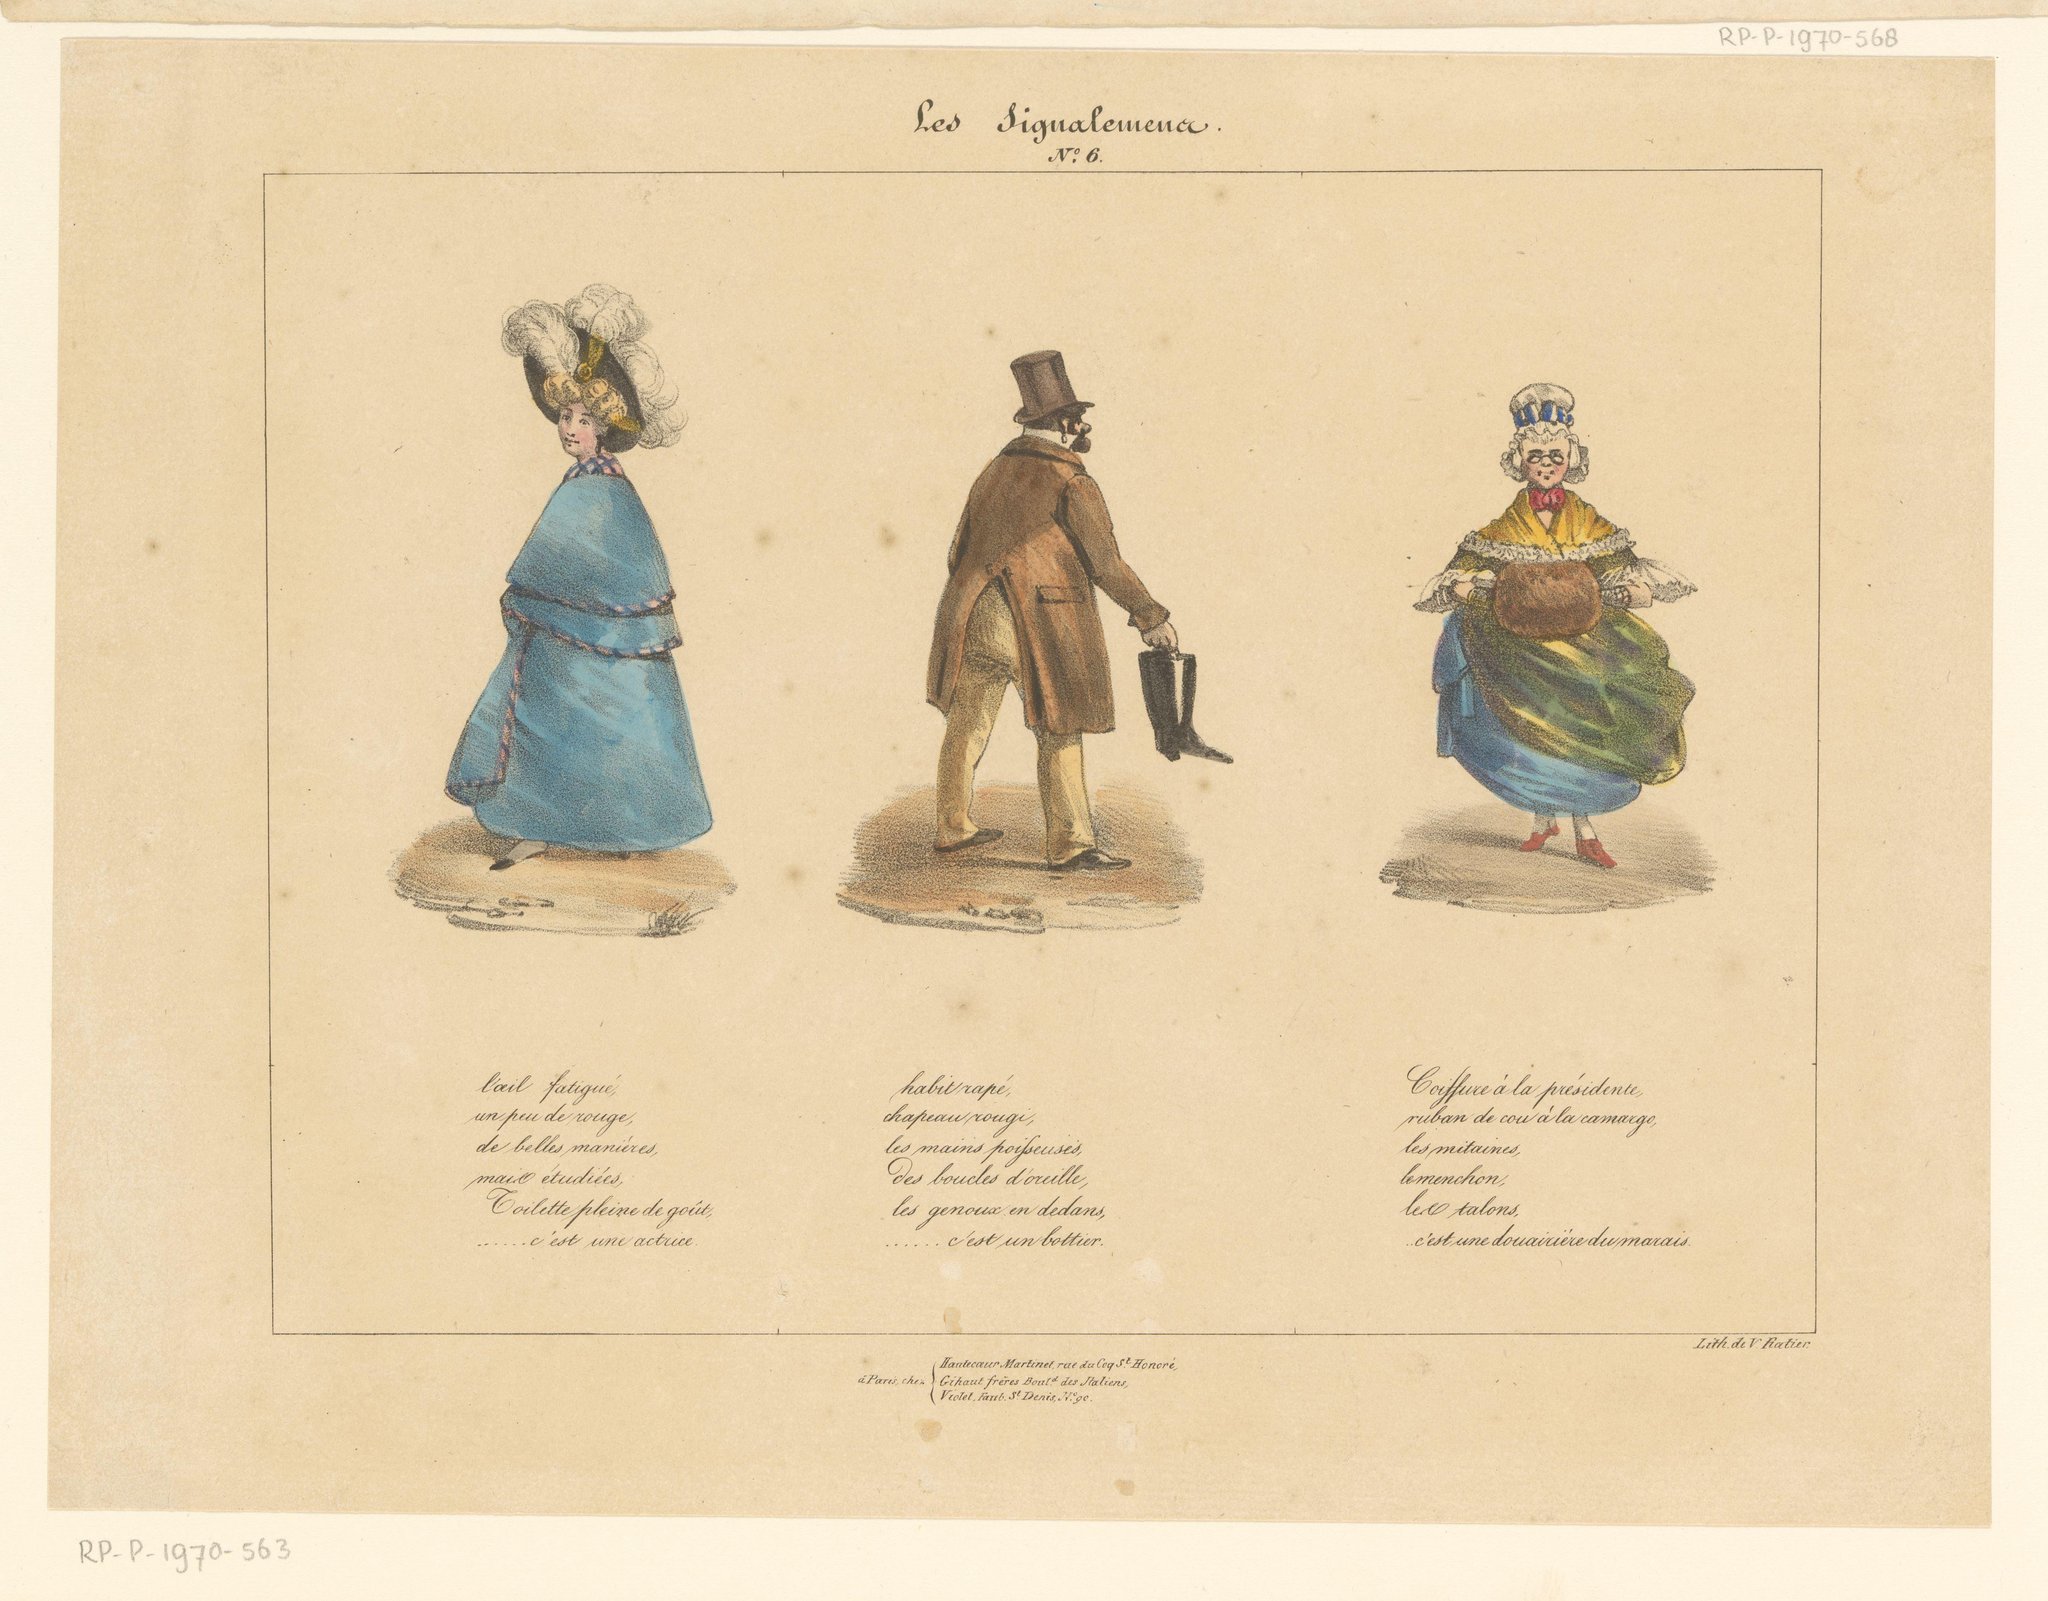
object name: print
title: Les signalements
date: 1829-1830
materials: paper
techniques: hand coloring, lithograph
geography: paris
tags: appearances, fashion, clothing, adult woman, adult man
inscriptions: collector's mark: Lugt 2228